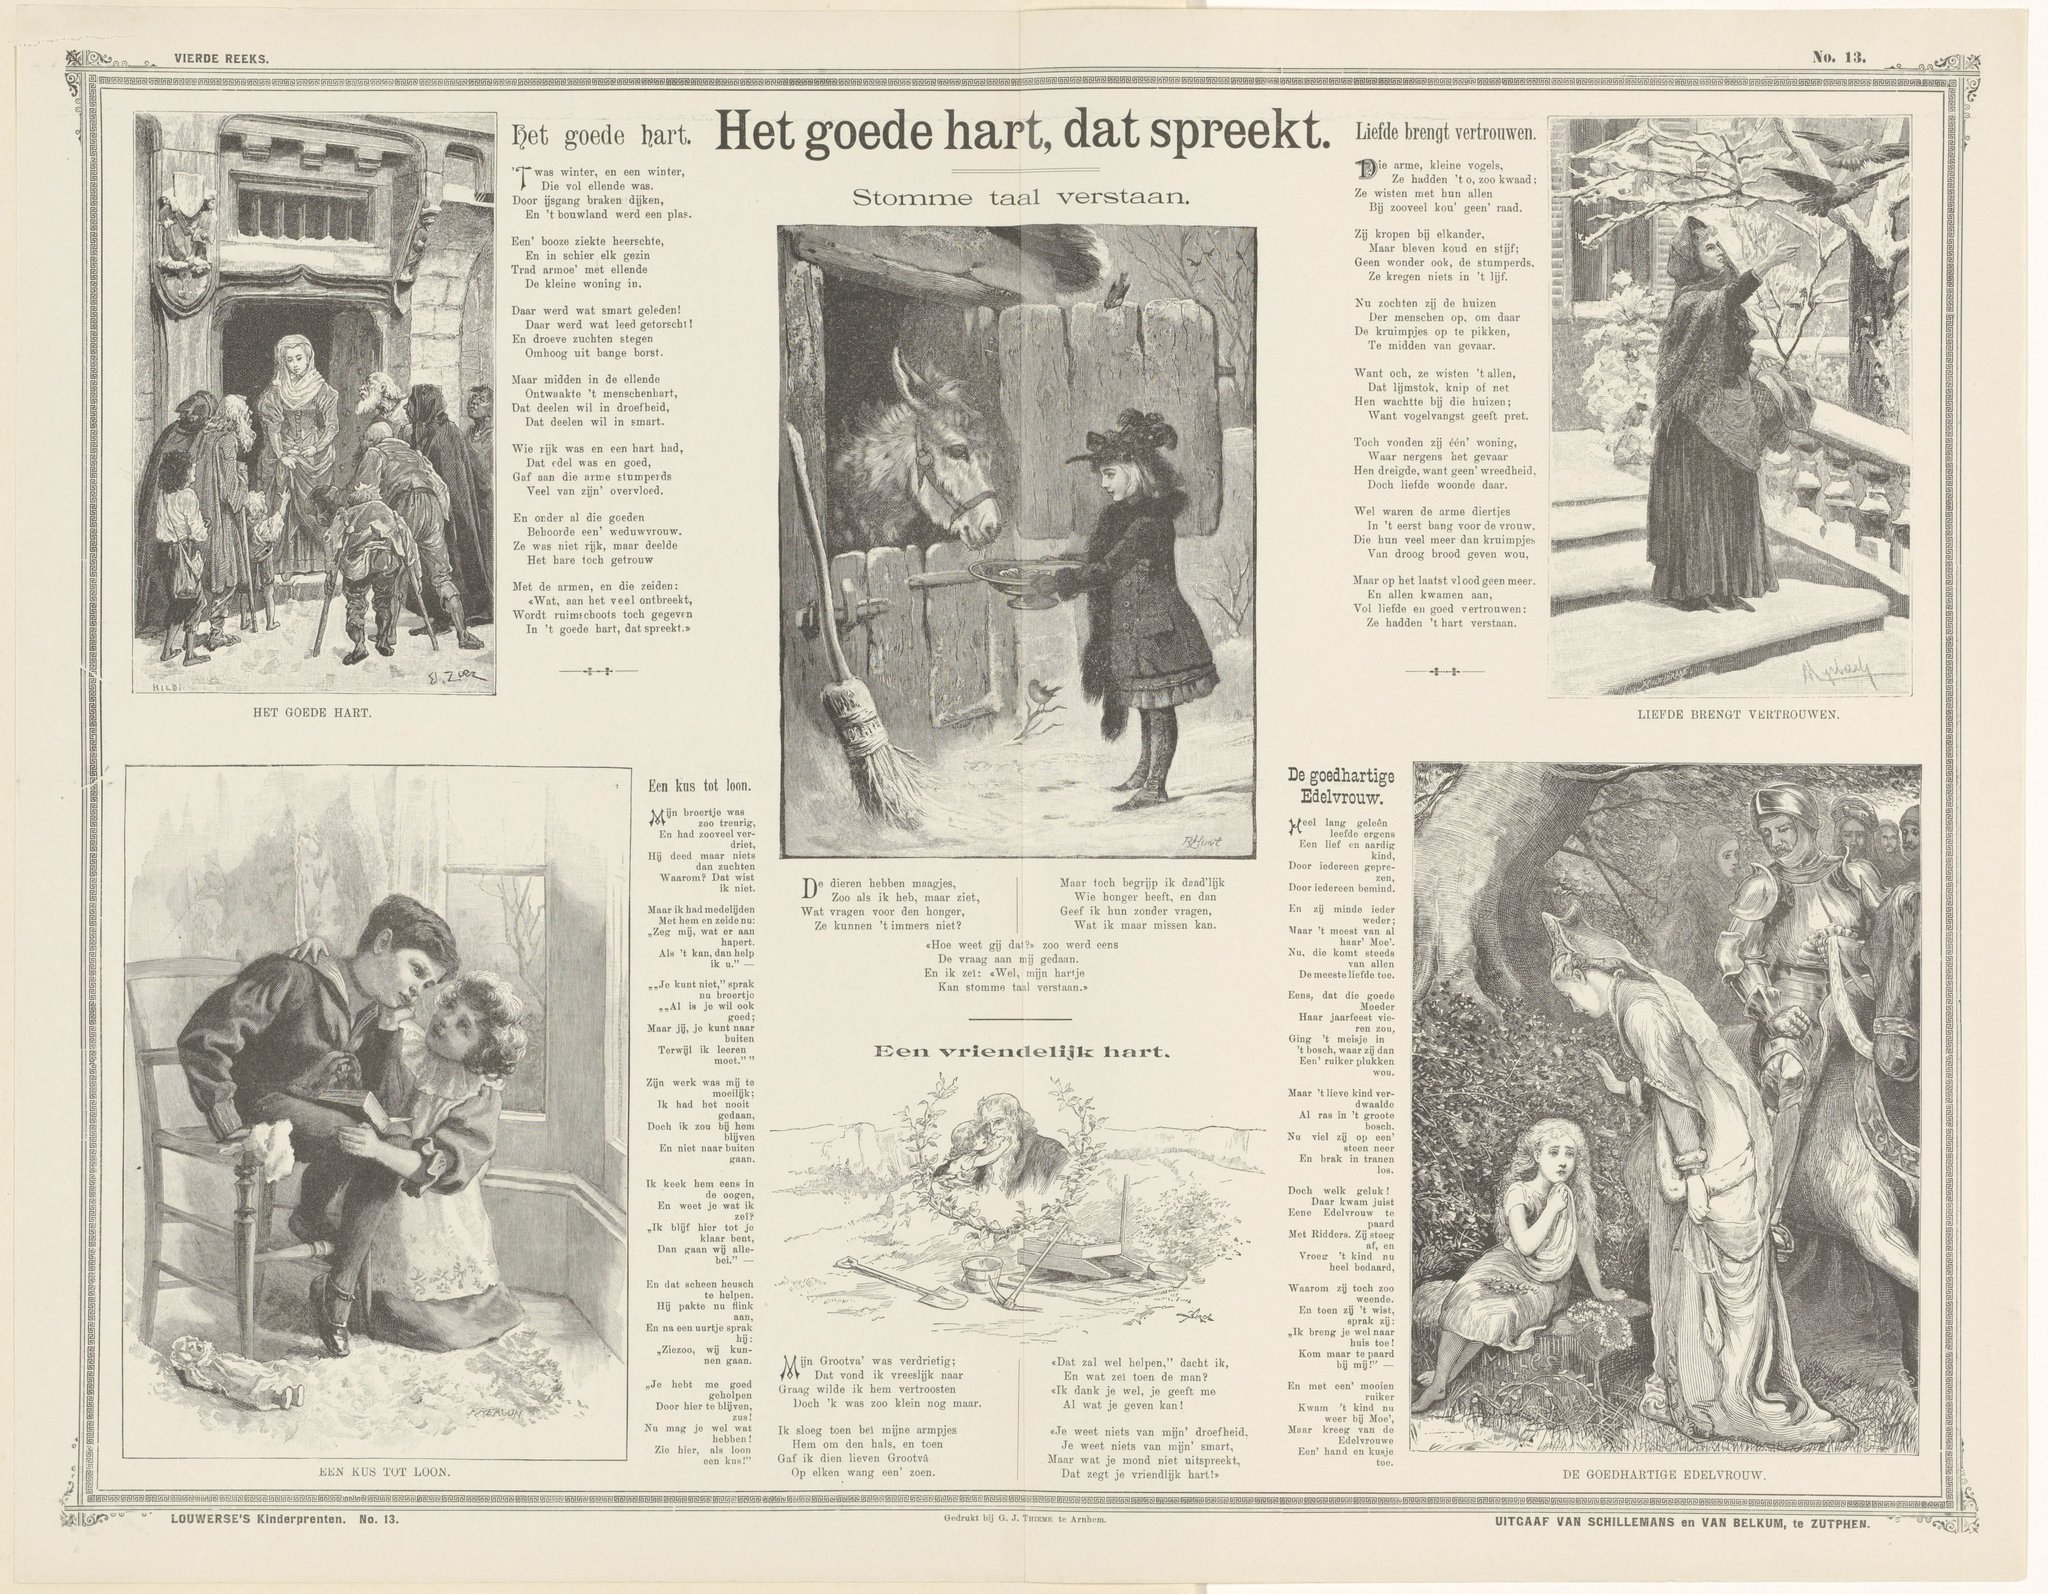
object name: popular print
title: Het goede hart, dat spreekt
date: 1905-1924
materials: paper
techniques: letterpress printing, printing block, engraving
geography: zutphen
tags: giving alms or other charity, e.g.: handing out food, helpfulness, animals (+ animals eating and drinking)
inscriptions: collector's mark: Lugt 2760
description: Blad met 6 voorstellingen van vriendelijke mensen die andere mensen en dieren helpen of iets te eten geven. Tussen de afbeeldingen versjes in boekdruk. Genummerd rechtsboven en linksonder: No. 13.